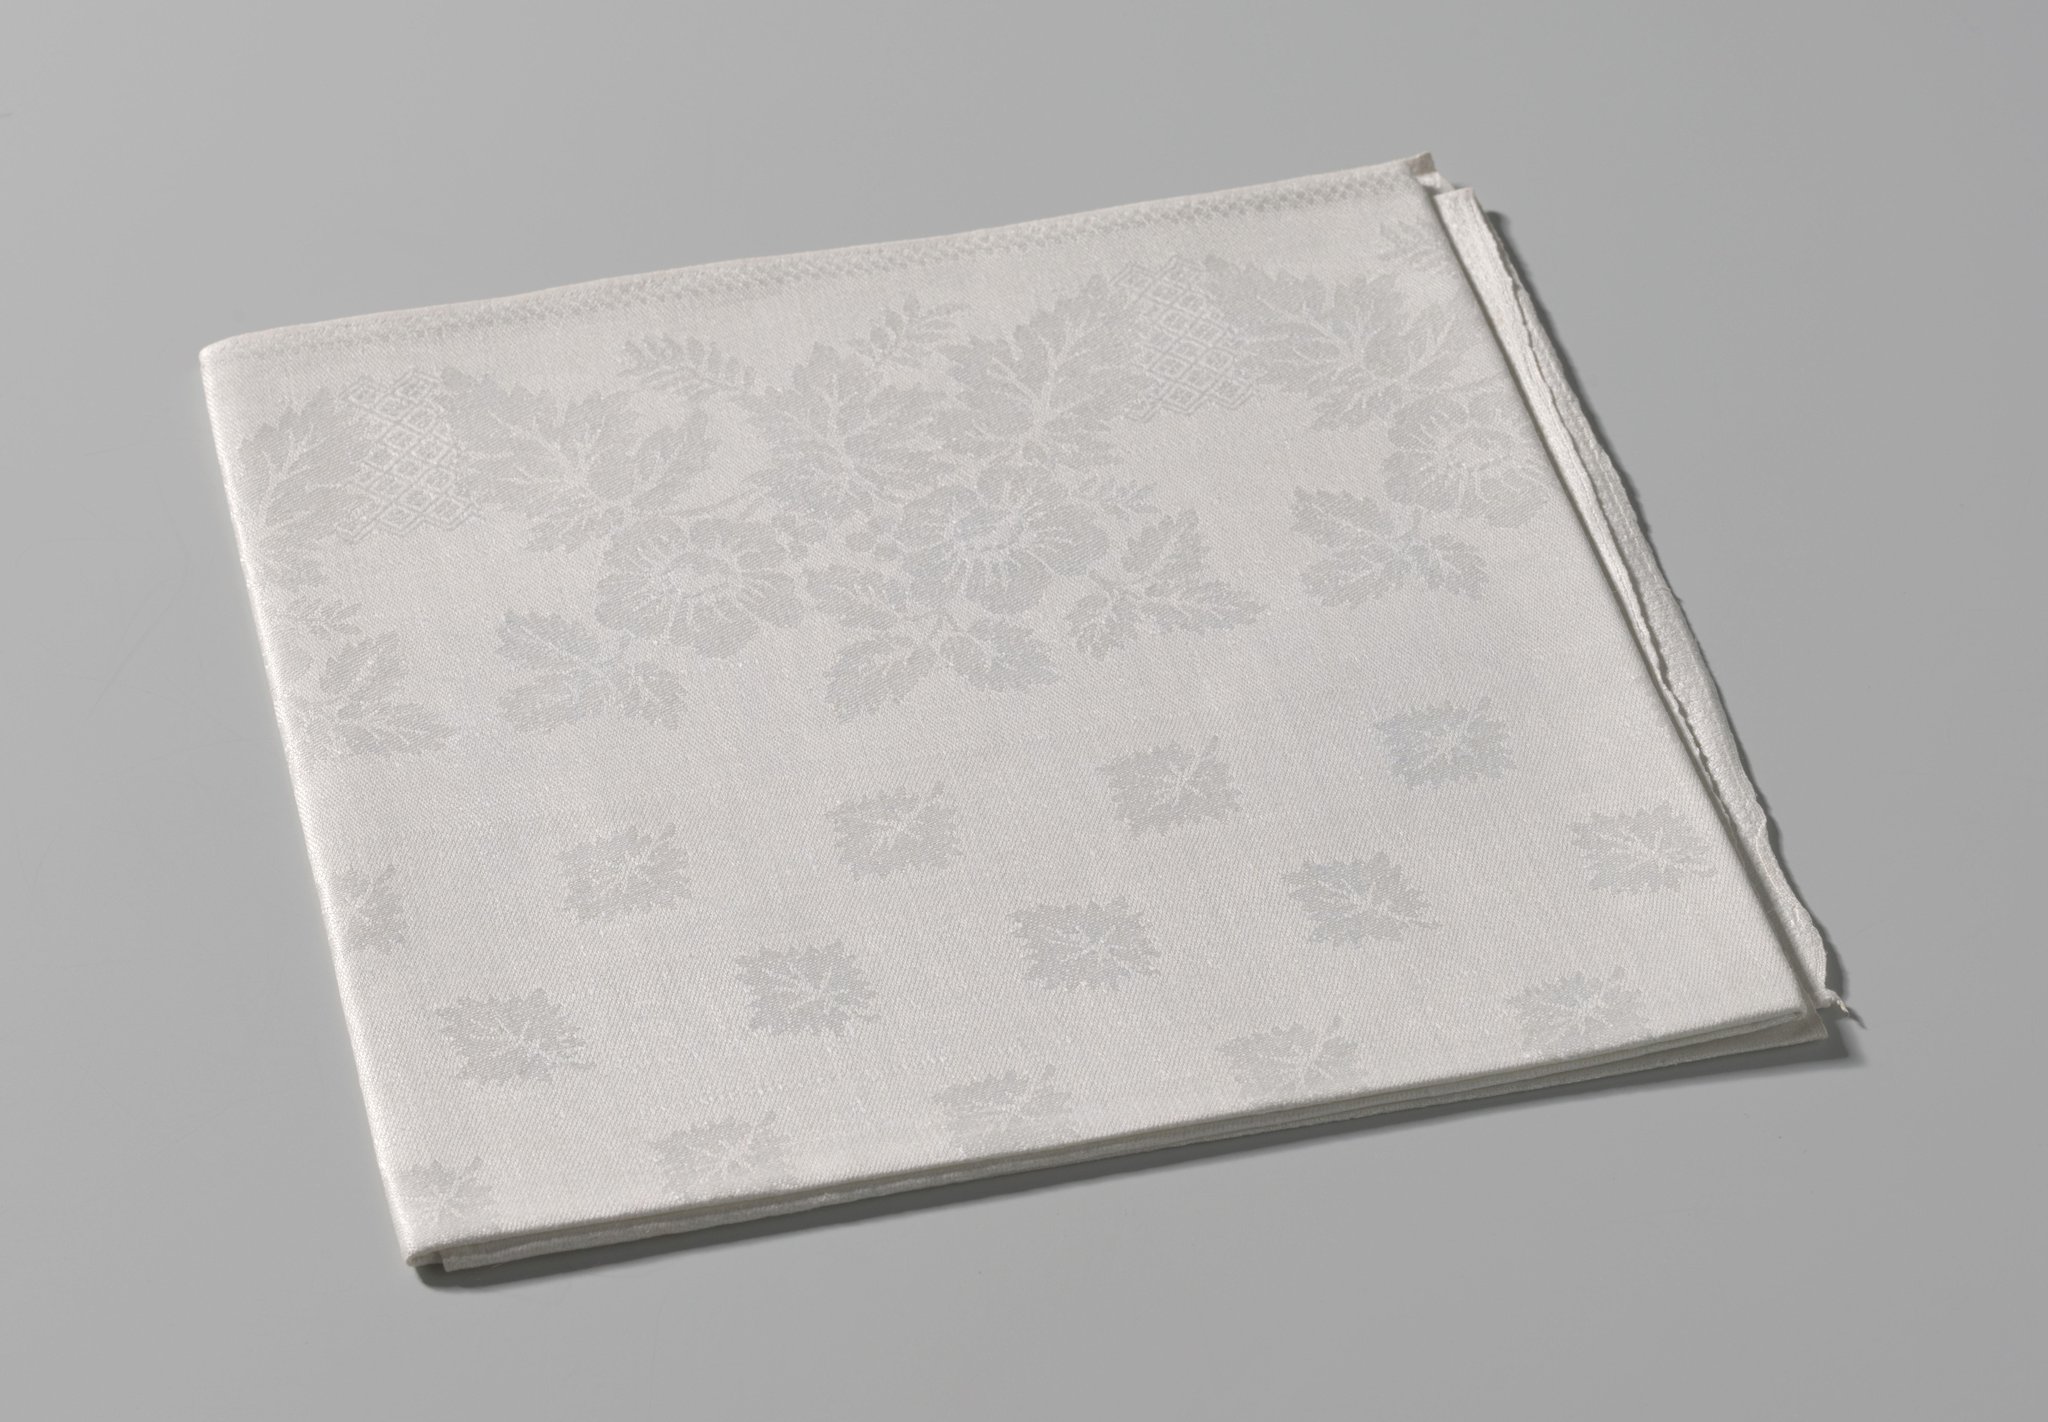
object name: napkin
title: Servet van wit linnendamast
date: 1859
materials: linen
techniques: damask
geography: borne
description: Wit linnen damasten servet met "appeltak", merk kroon H .